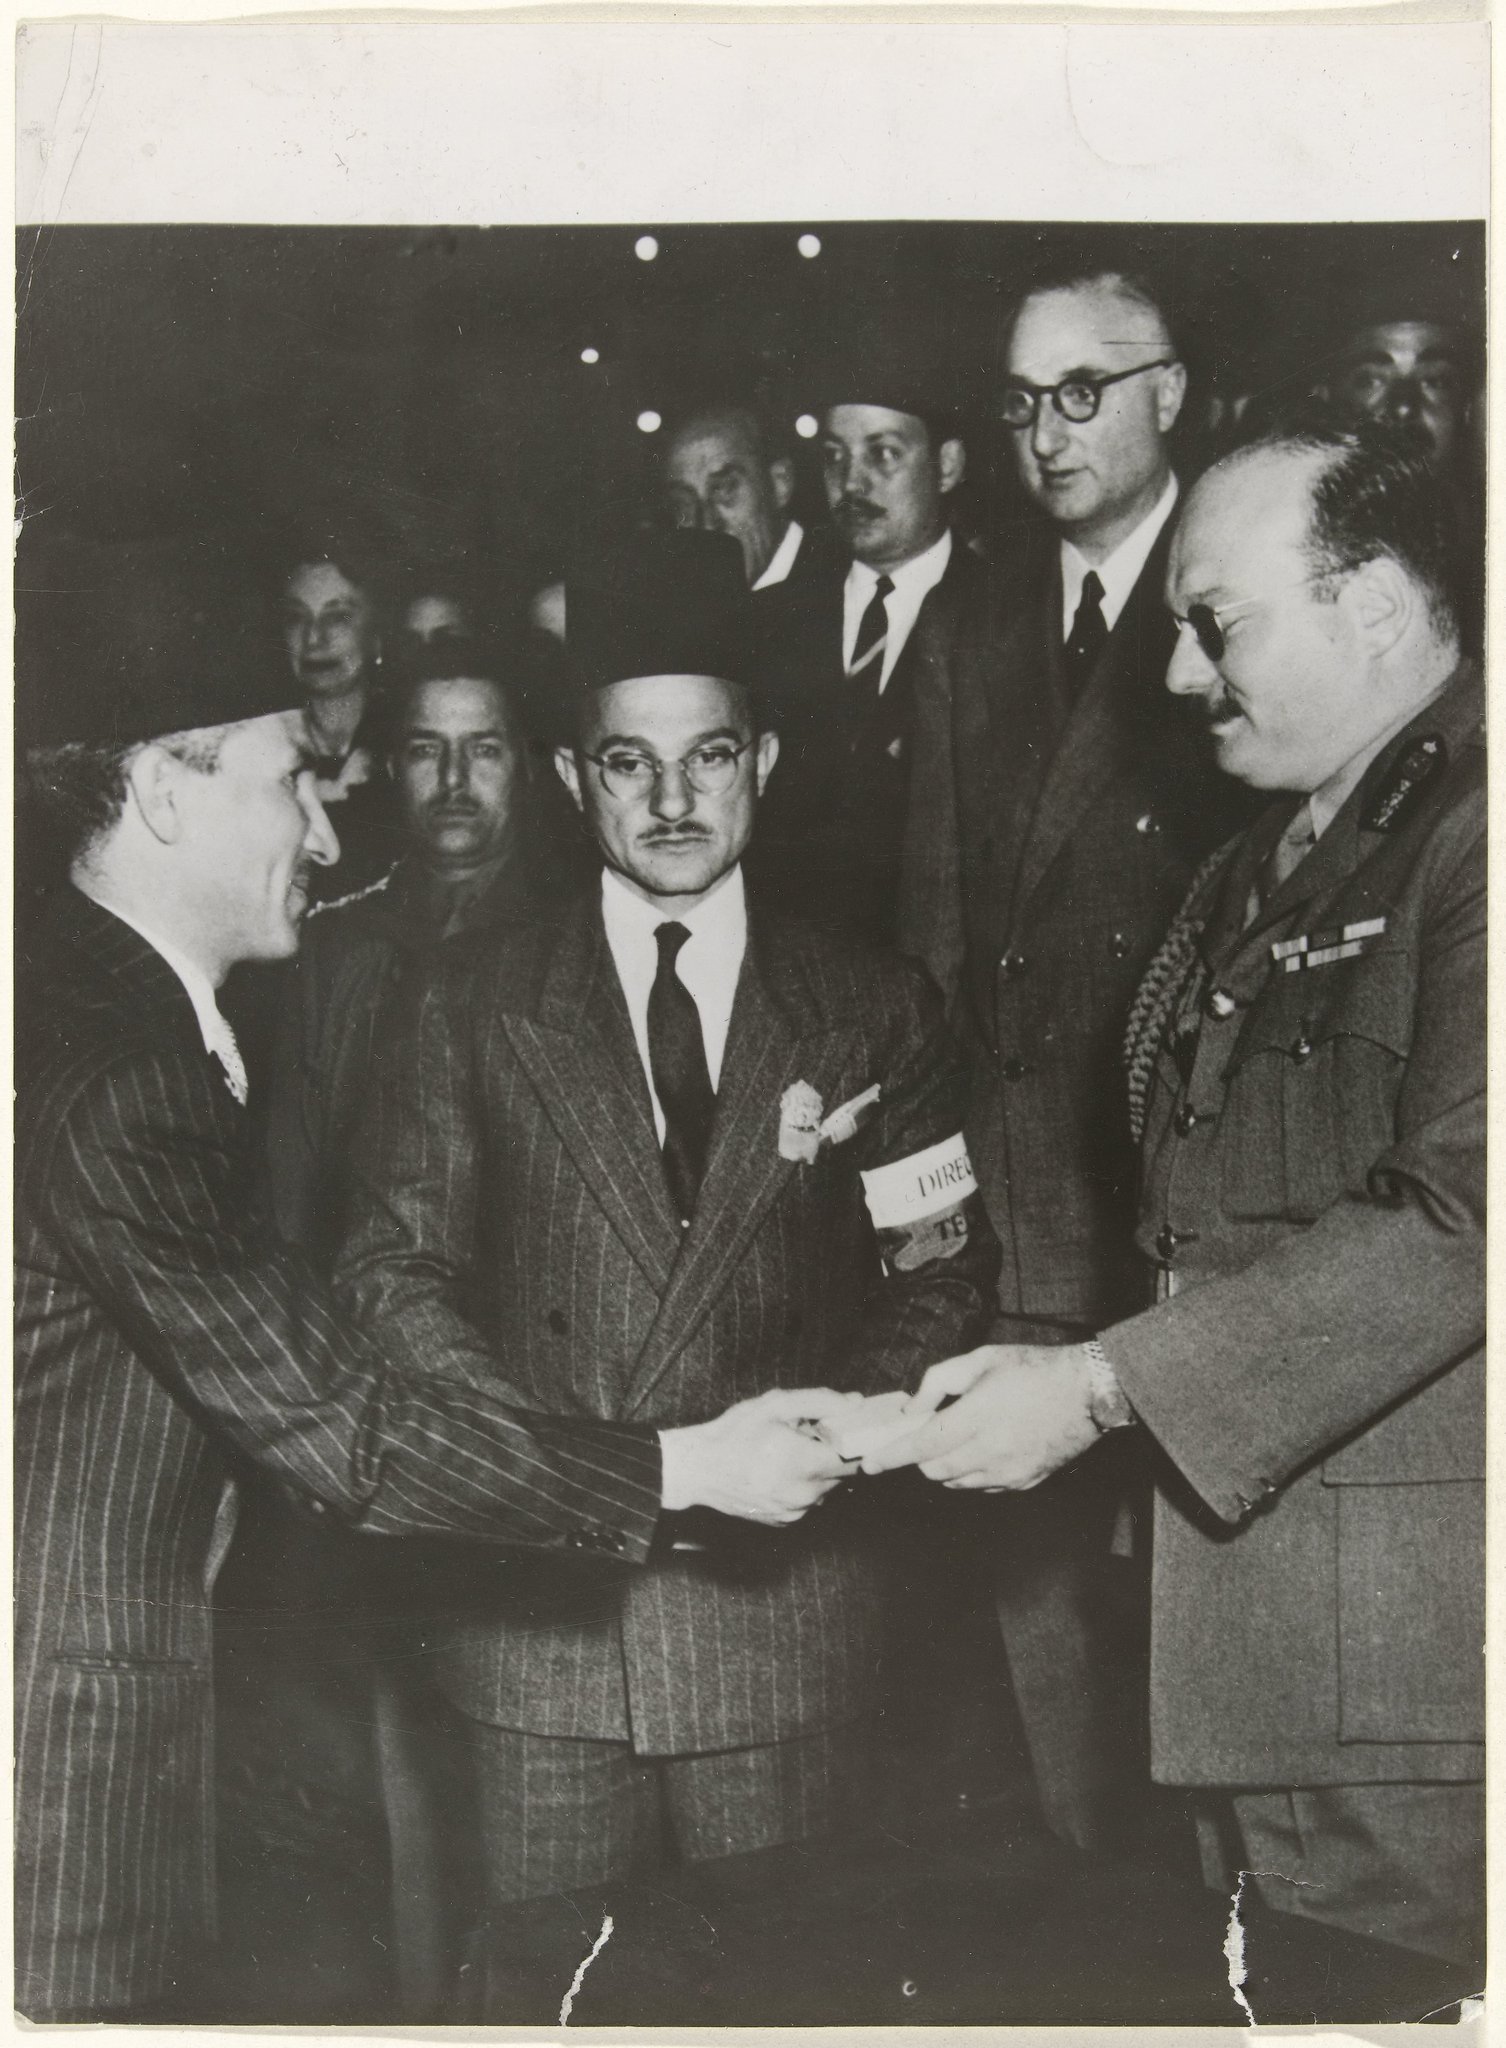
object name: photograph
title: Koning Farouk reikt prijs uit bij wedstrijd schermen Cairo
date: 1936-1952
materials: photographic support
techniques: gelatin silver print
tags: caïro, koning, farouk i (koning van egypte), egypte